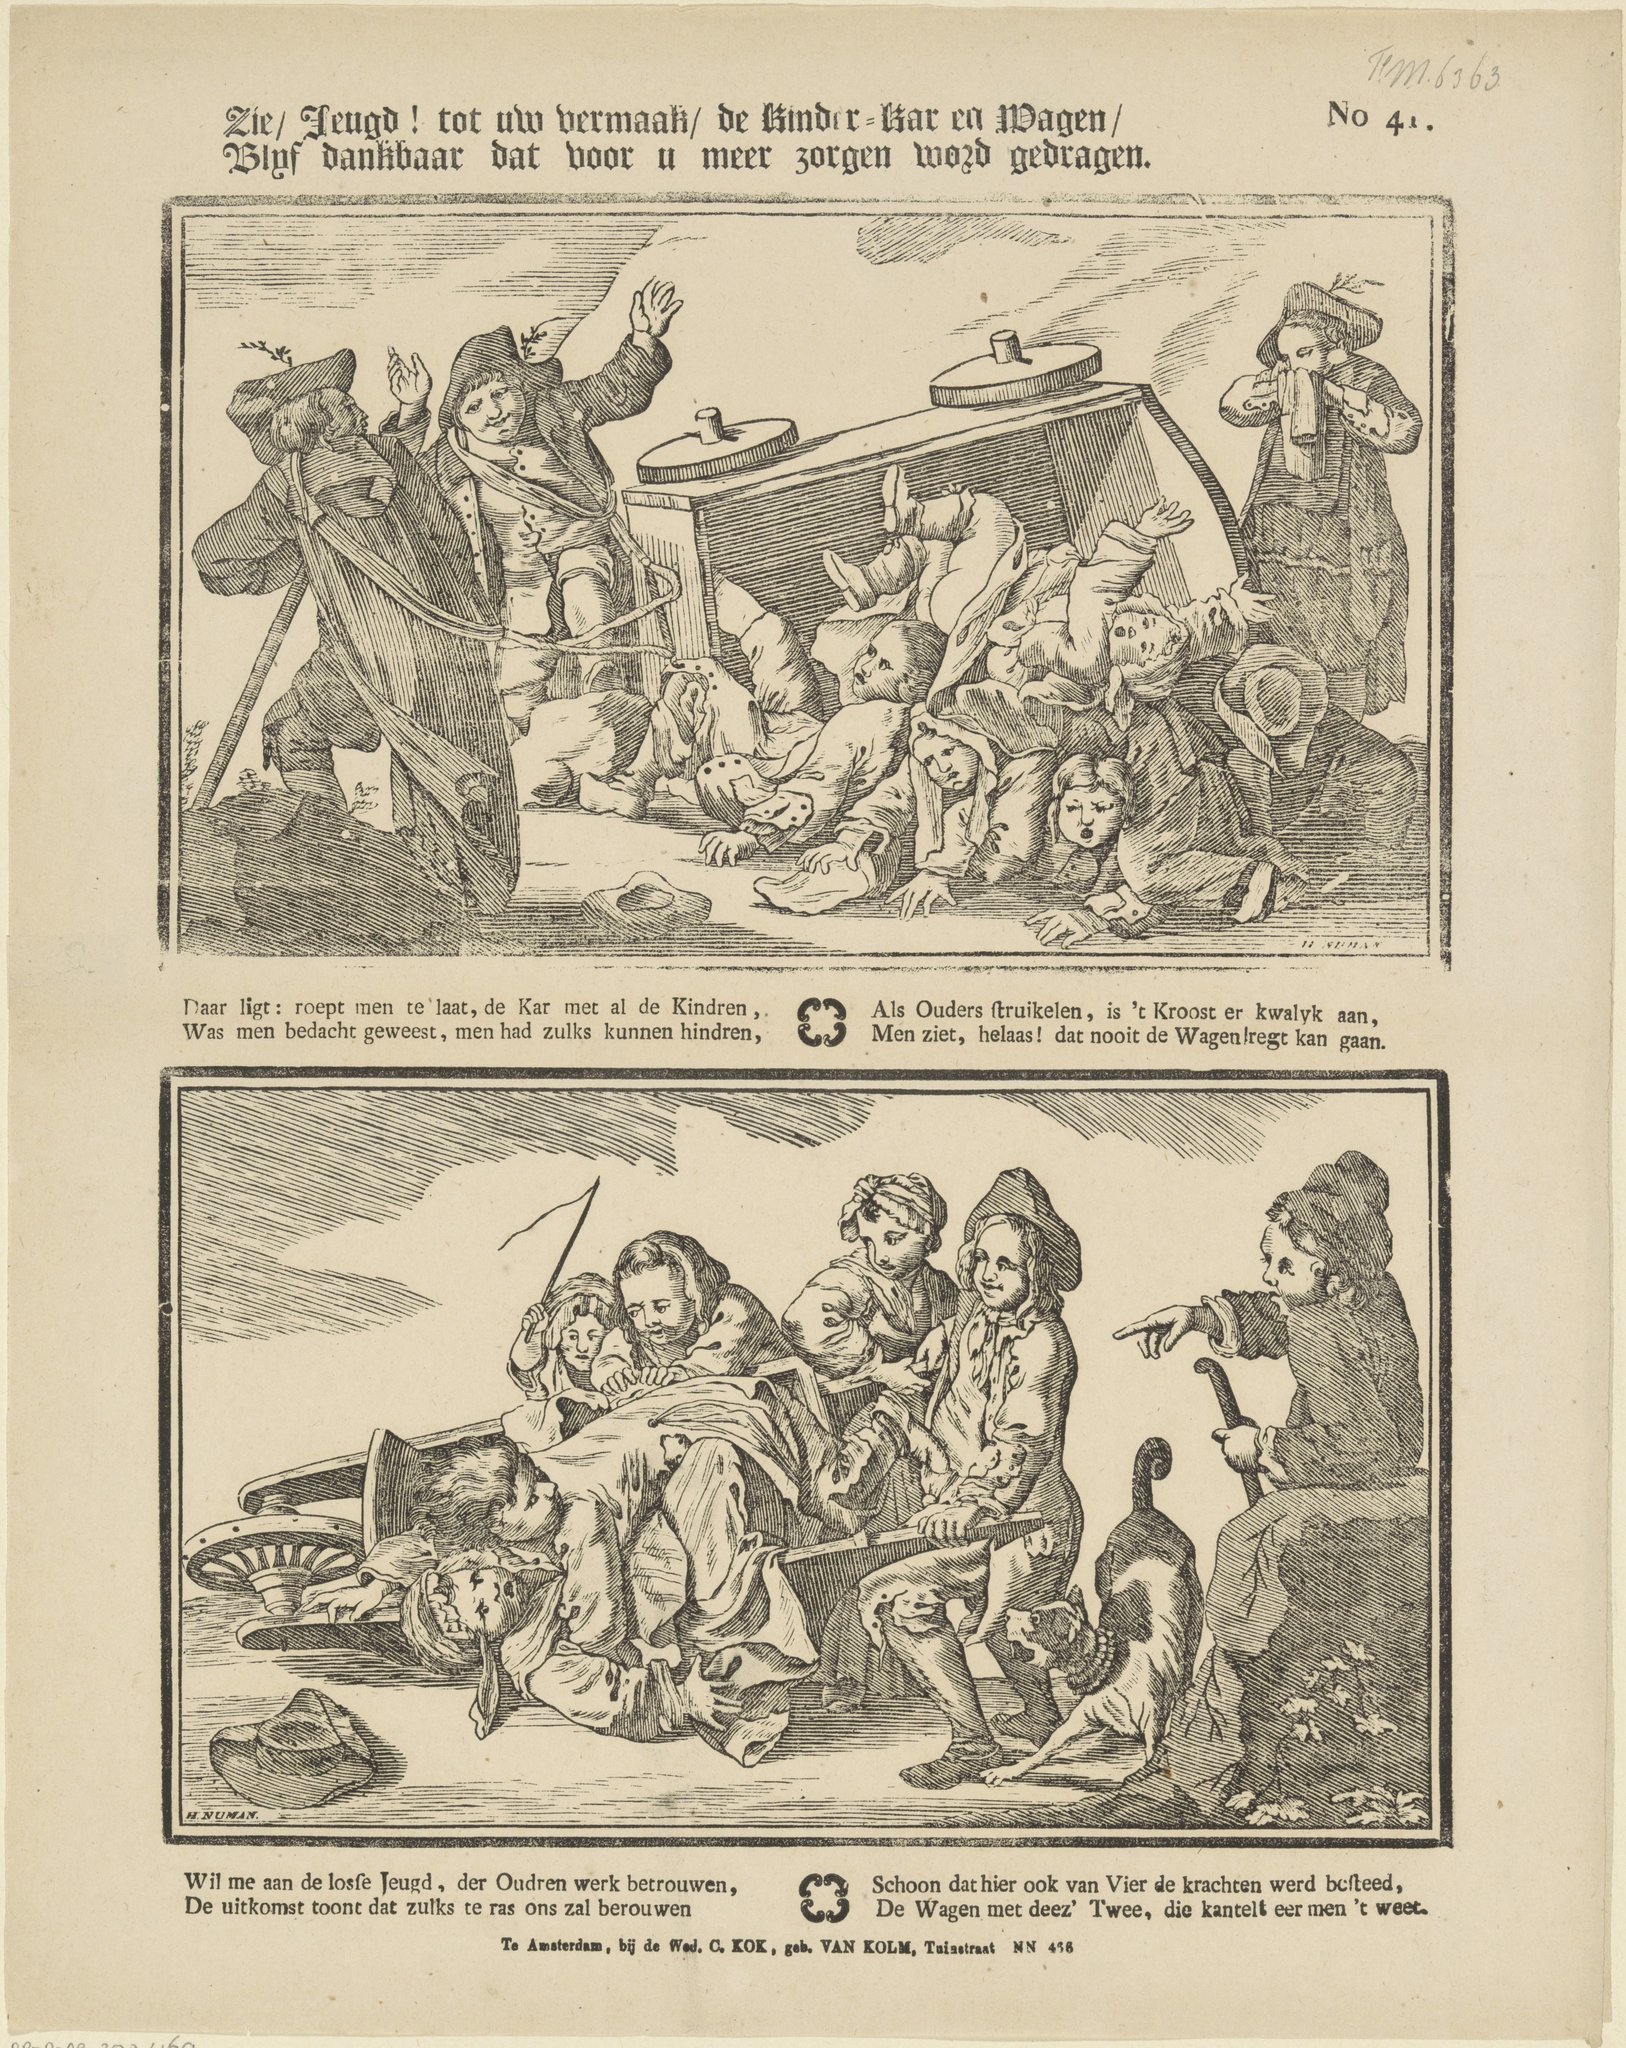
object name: print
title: Zie / jeugd! tot uw vermaak / de kinder-kar en wagen / Blyf dankbaar dat voor u meer zorgen word gedragen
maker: weduwe c. kok geboren van kolm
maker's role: printer, publisher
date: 1842-1866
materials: paper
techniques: letterpress printing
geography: amsterdam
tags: baby-carriage, pram, perambulator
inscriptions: collector's mark: Lugt 2760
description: Blad met 2 voorstellingen. Boven: een trekkar valt om waardoor de kinderen die er in zaten op de grond vallen. Onder: een kruier gooit een kruiwagen om waardoor de kinderen die er in zaten op de grond vallen. Onder elke afbeelding een vierregelig vers. Genummerd rechtsboven: No. 41.